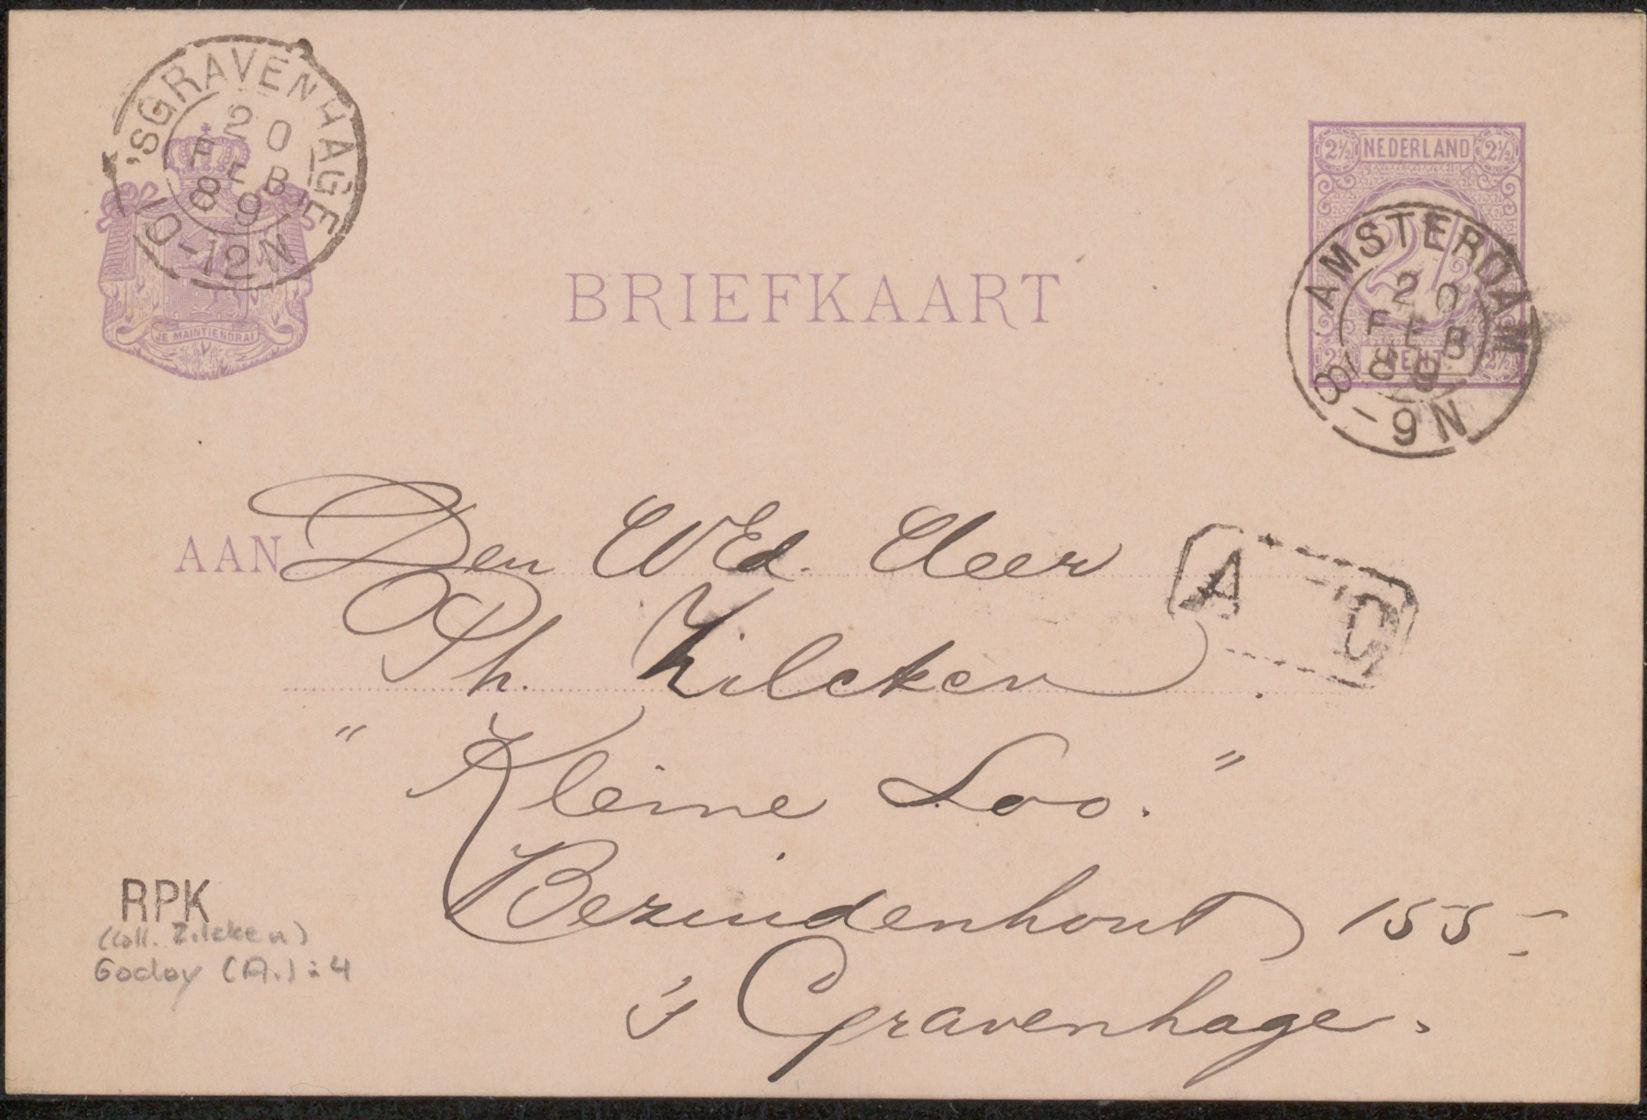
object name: postcard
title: Briefkaart aan Philip Zilcken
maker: adèle josephine godoy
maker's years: 1863-1918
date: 1889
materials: cardboard, ink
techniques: pen, writing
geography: amsterdam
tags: the hague, painter, draughtsman, philip zilcken, literature ~ arts, the graphic arts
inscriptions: collector's mark: ‘RPK’